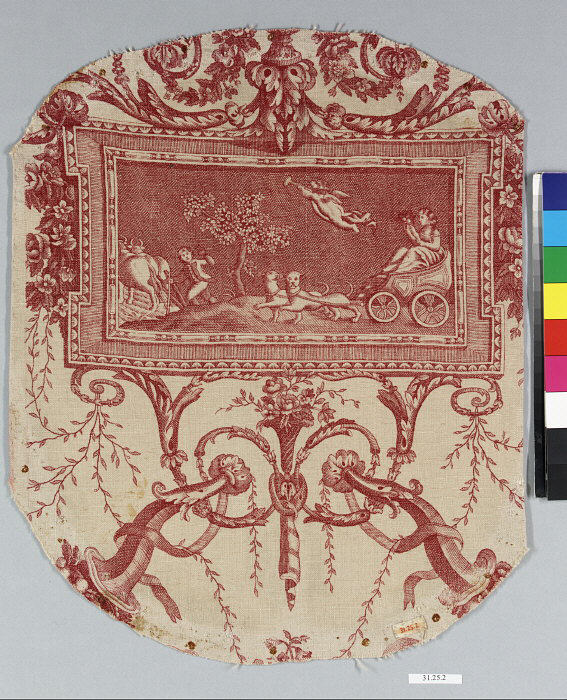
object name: fragment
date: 1701-1800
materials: linen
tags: men,women,ceres,cows,dogs,flowers,trees,angels,carriages